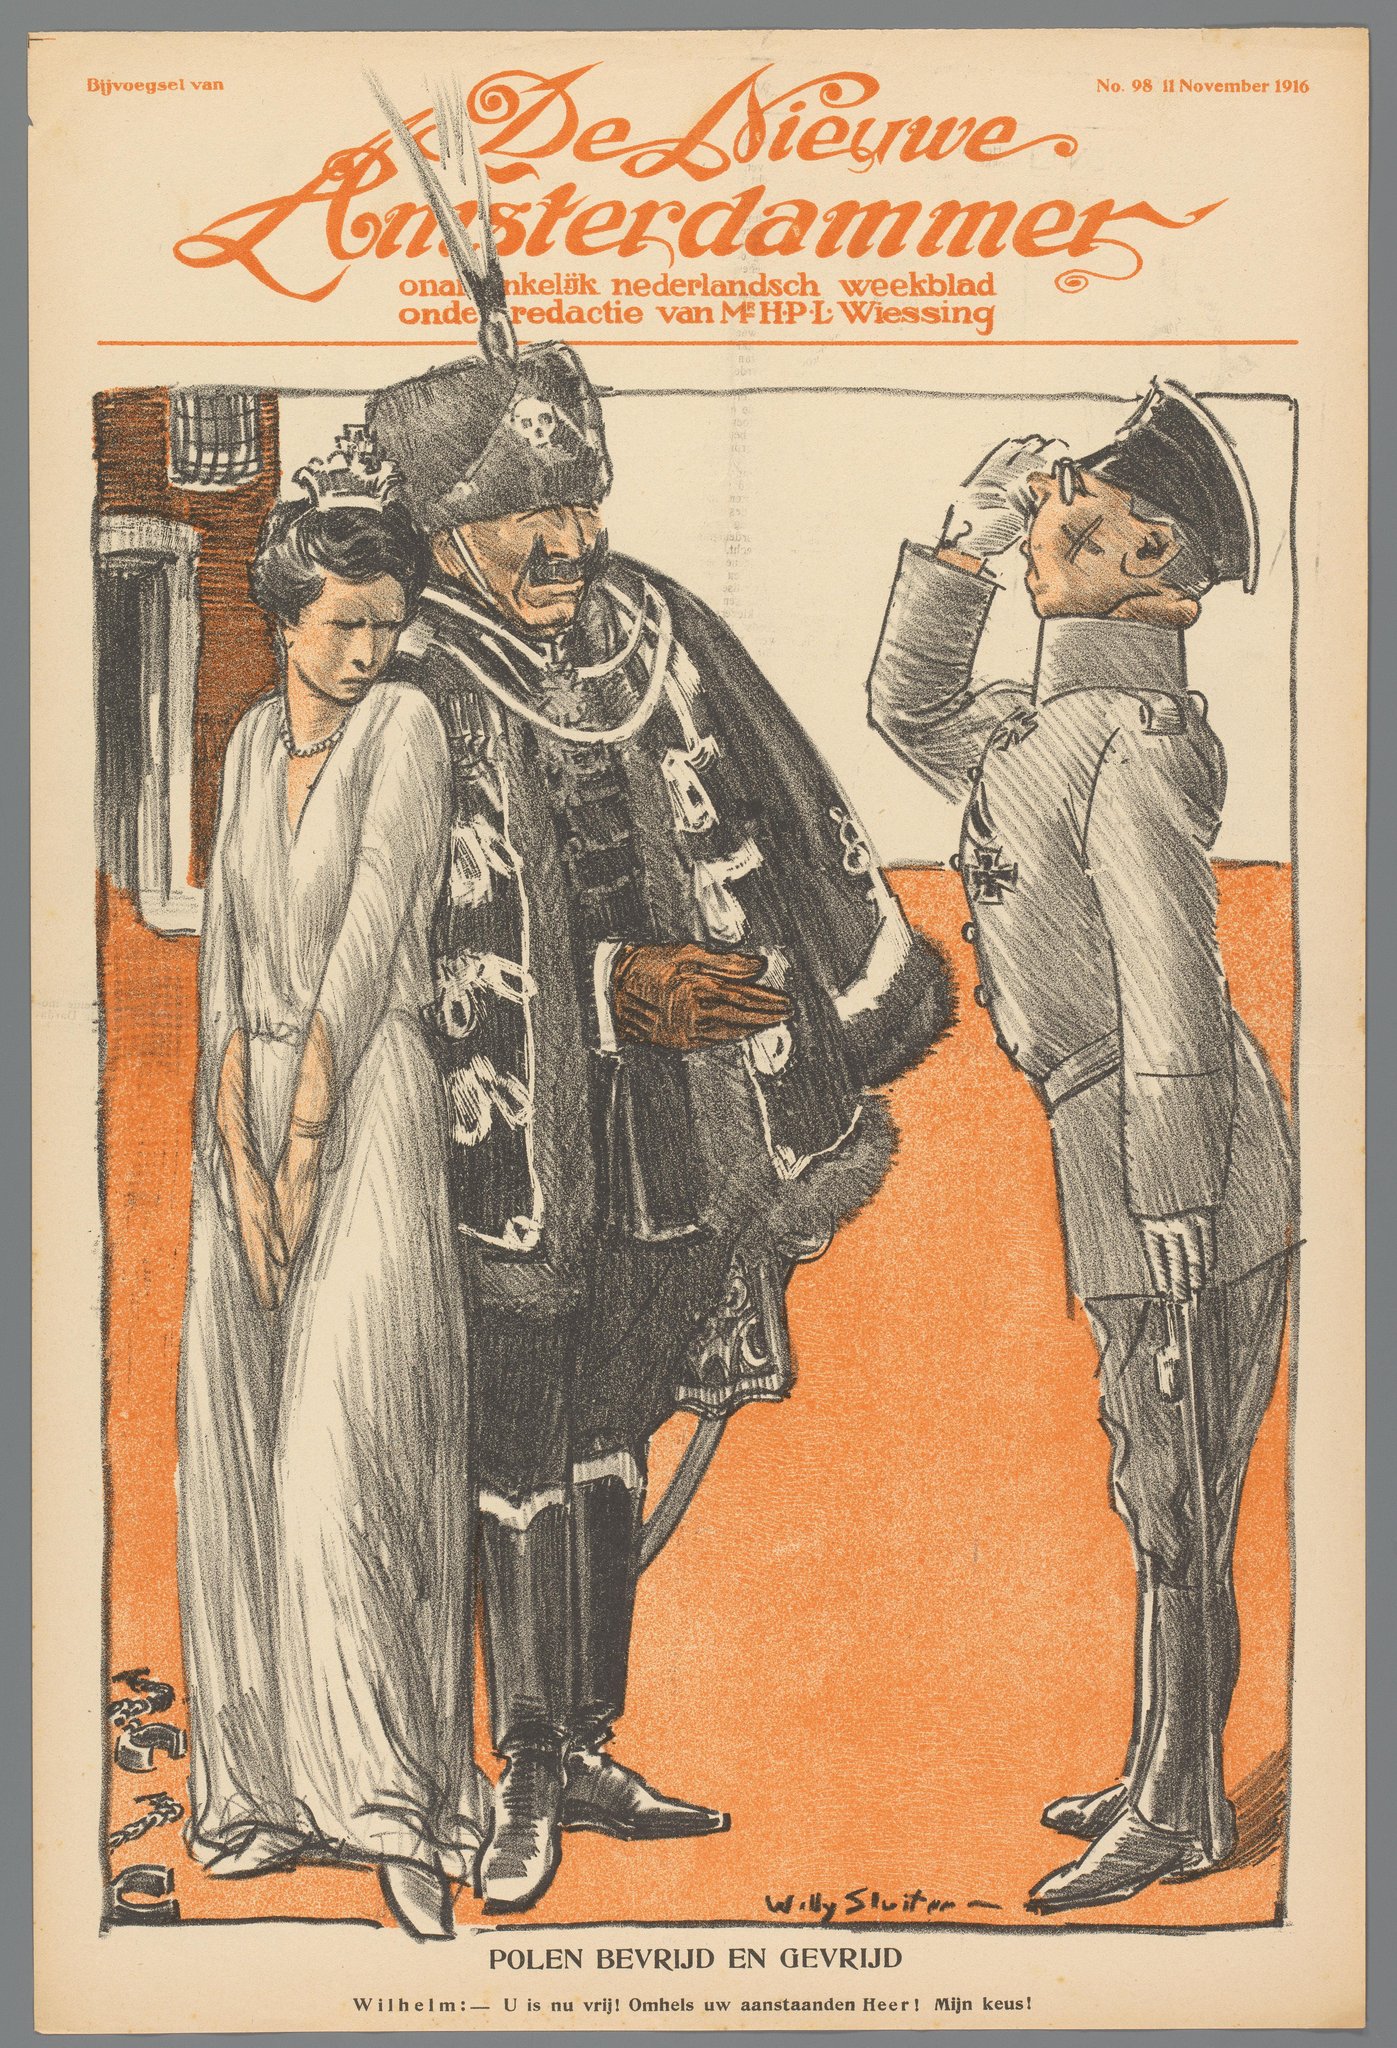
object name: cartoon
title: Polen bevrijd en gevrijd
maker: willy sluiter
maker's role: draughtsman, painter, print maker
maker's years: 1873-1949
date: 1916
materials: paper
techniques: lithograph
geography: netherlands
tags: wilhelm ii (keizer van duitsland), personifications of countries, nations, states, districts, etc. (+ nation; national), political caricatures and satires, poland, germany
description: De Duitse keizer Wilhelm II staande naast de personificatie van Polen stelt haar voor aan haar aanstaande echtgenoot, een Pruisische officier. Spotprent over de Eerste Wereldoorlog, 11 november 1916.